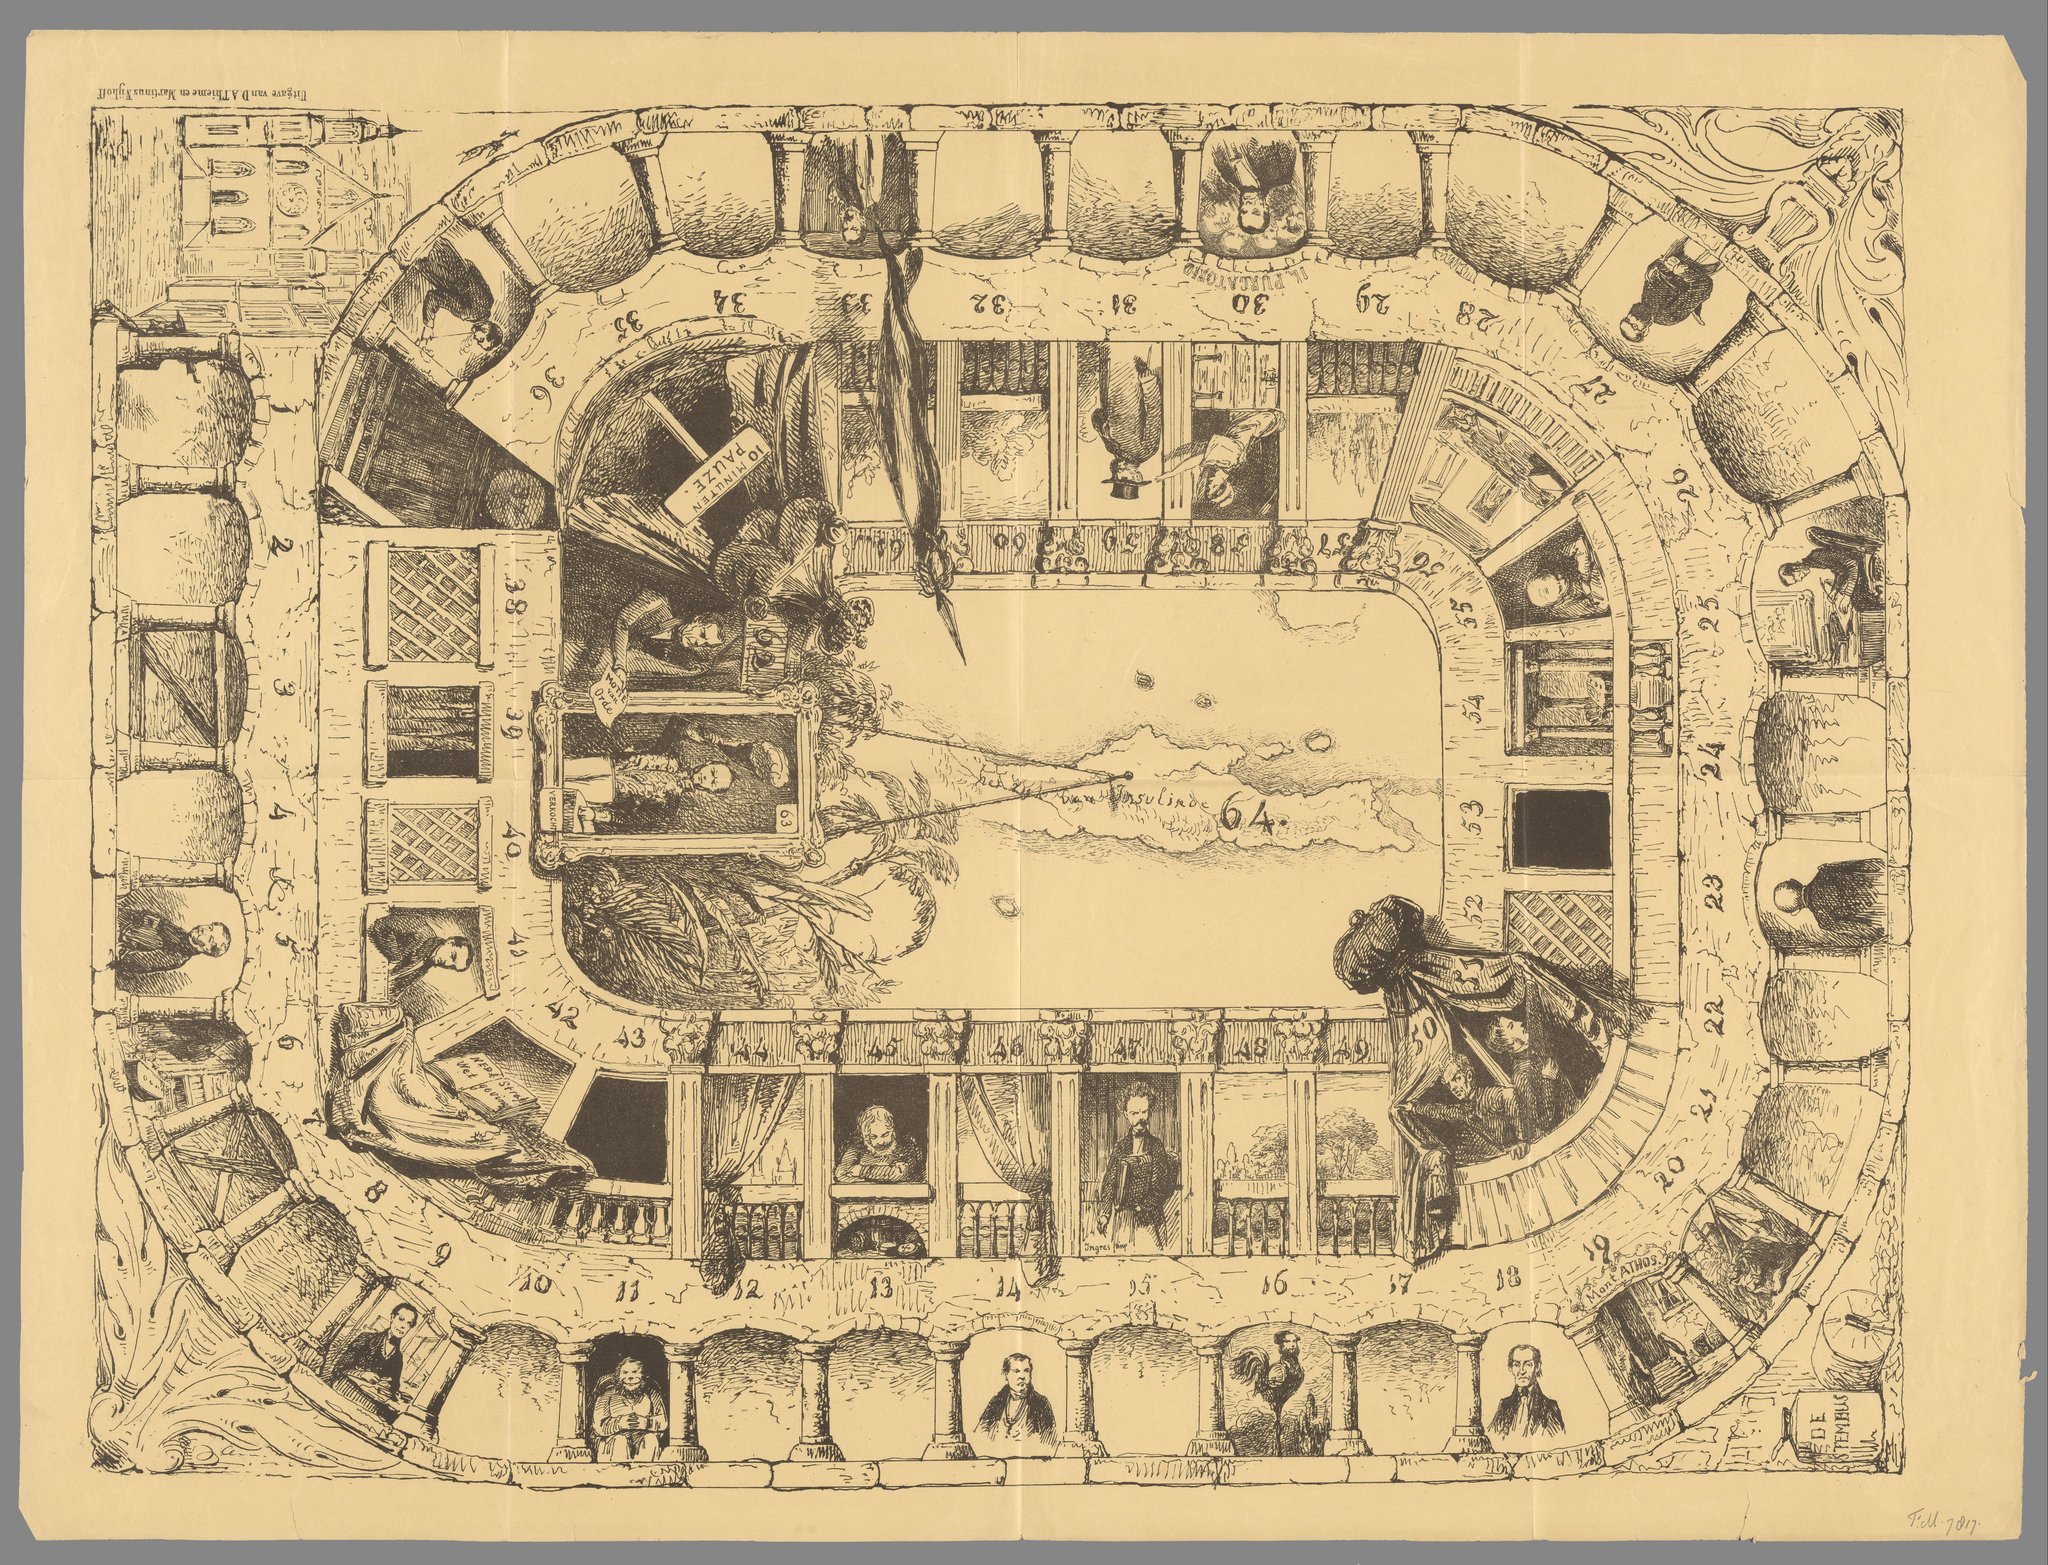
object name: cartoon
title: De Stembus. Politiek Ganzenbord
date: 1867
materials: paper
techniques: lithograph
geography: netherlands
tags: batavia, minister ~ government, goose-game, java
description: Spotprent in de vorm van een ganzenbord waarin meerdere portretten van ministers zijn opgenomen. Het spel begint bij het Binnenhof in Den Haag en eindigt met een geschilderd portret van Pieter Mijer gehangen aan het eiland Java (Insulinde). Bij het spel een los blad met de spelregels. Plaat verschenen bij het weekblad De Nederlandsche Spectator, nr. 9, 2 maart 1867.